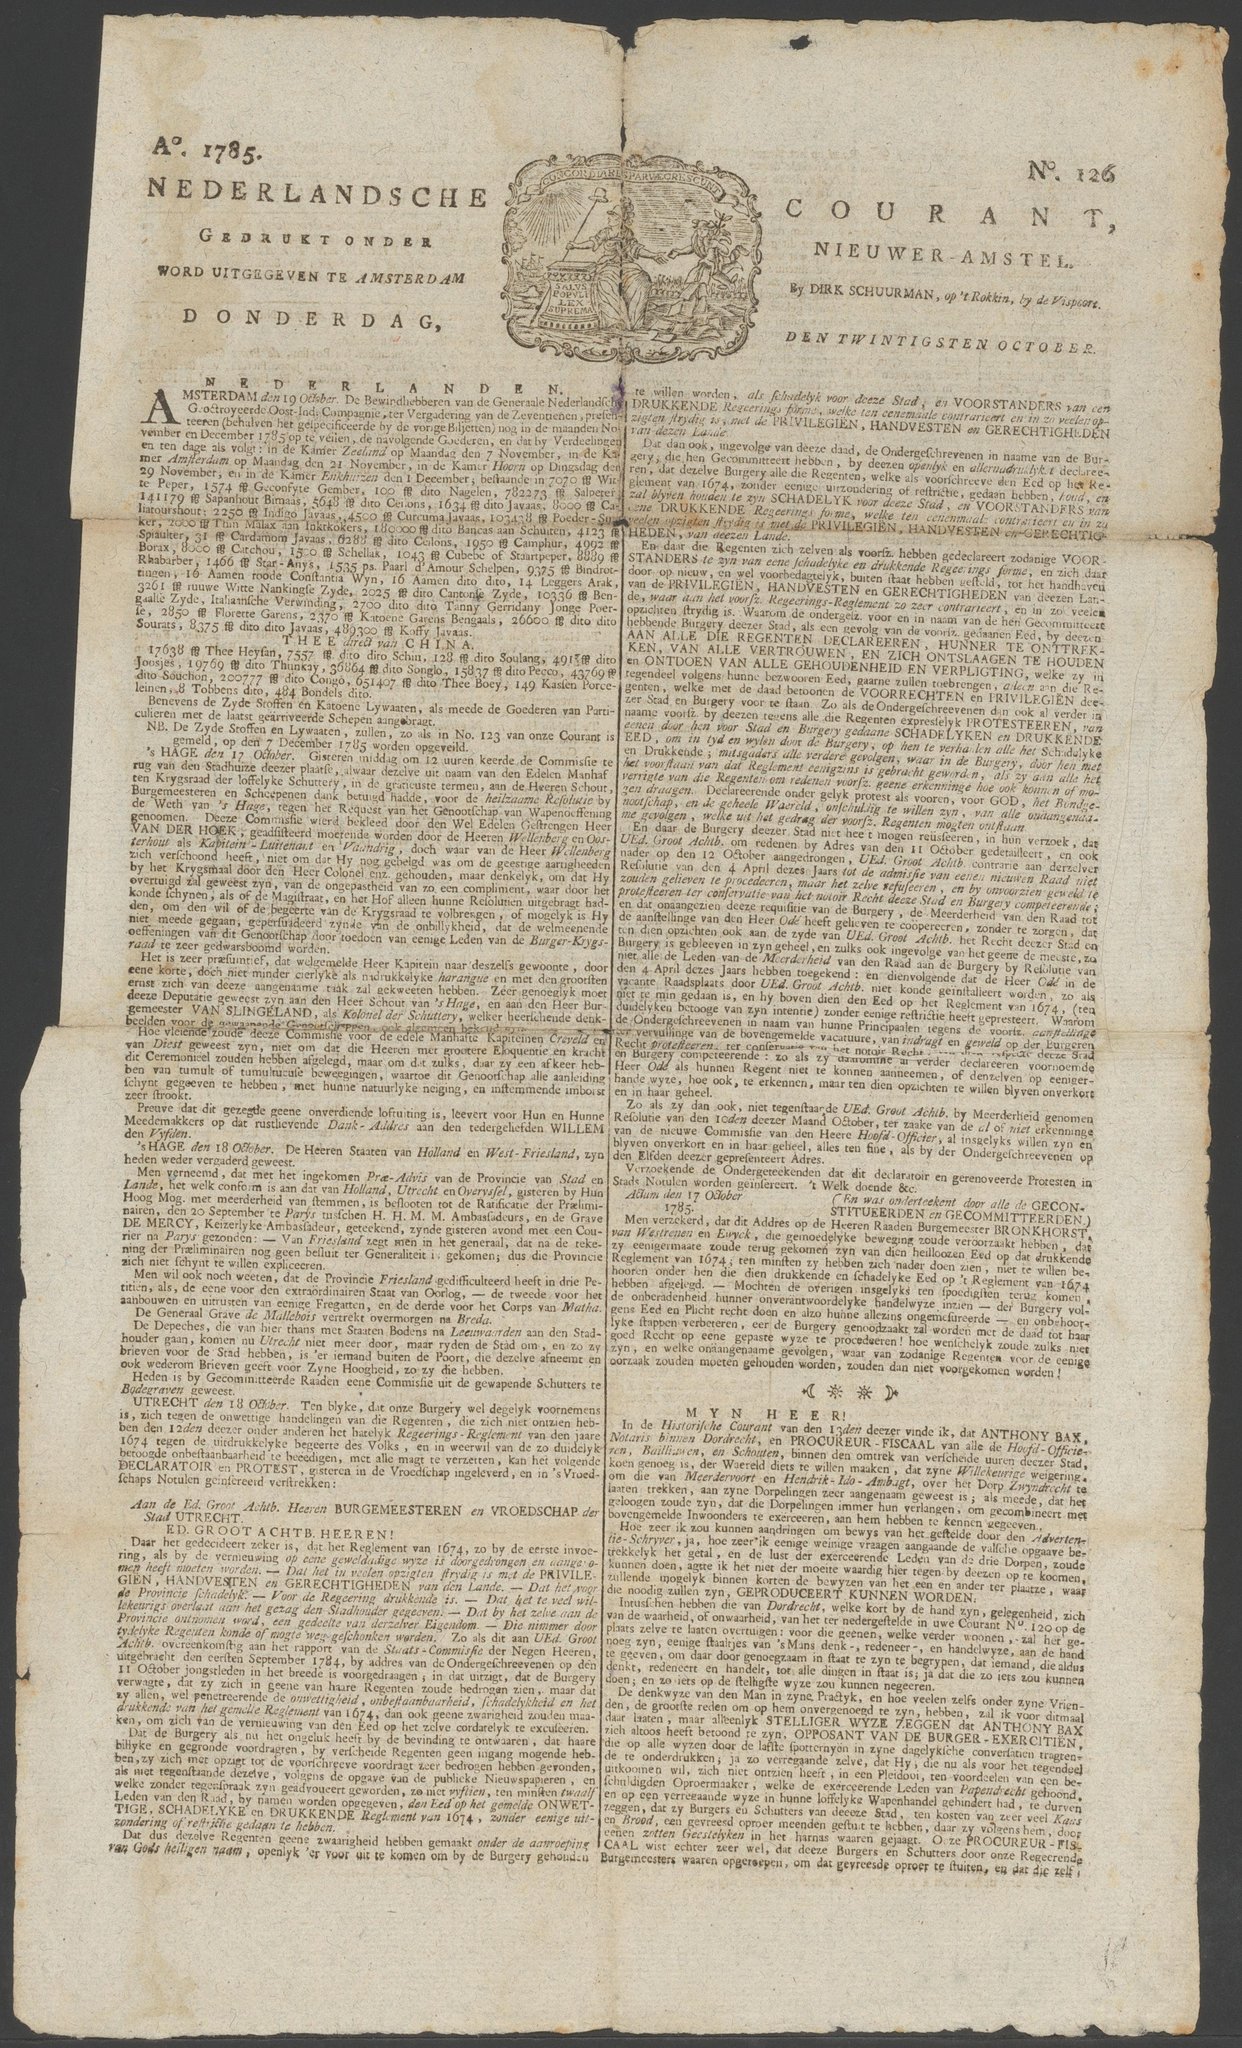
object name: newspaper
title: Nederlandsche Courant, 20 oktober 1785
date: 1785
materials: paper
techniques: letterpress printing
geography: nieuwer-amstel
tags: newspaper, news-sheet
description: Exemplaar van de krant 'Nederlandsche Courant' van 20 oktober 1785. Enkelbladig, beide zijden bedrukt. Bovenaan een vignet met de Vrijheid en Mercurius. Onderwerpsrubrieken binnen de Atlas Zeden en Gewoonten: Regeering, Officieele Nieuwsbladen.